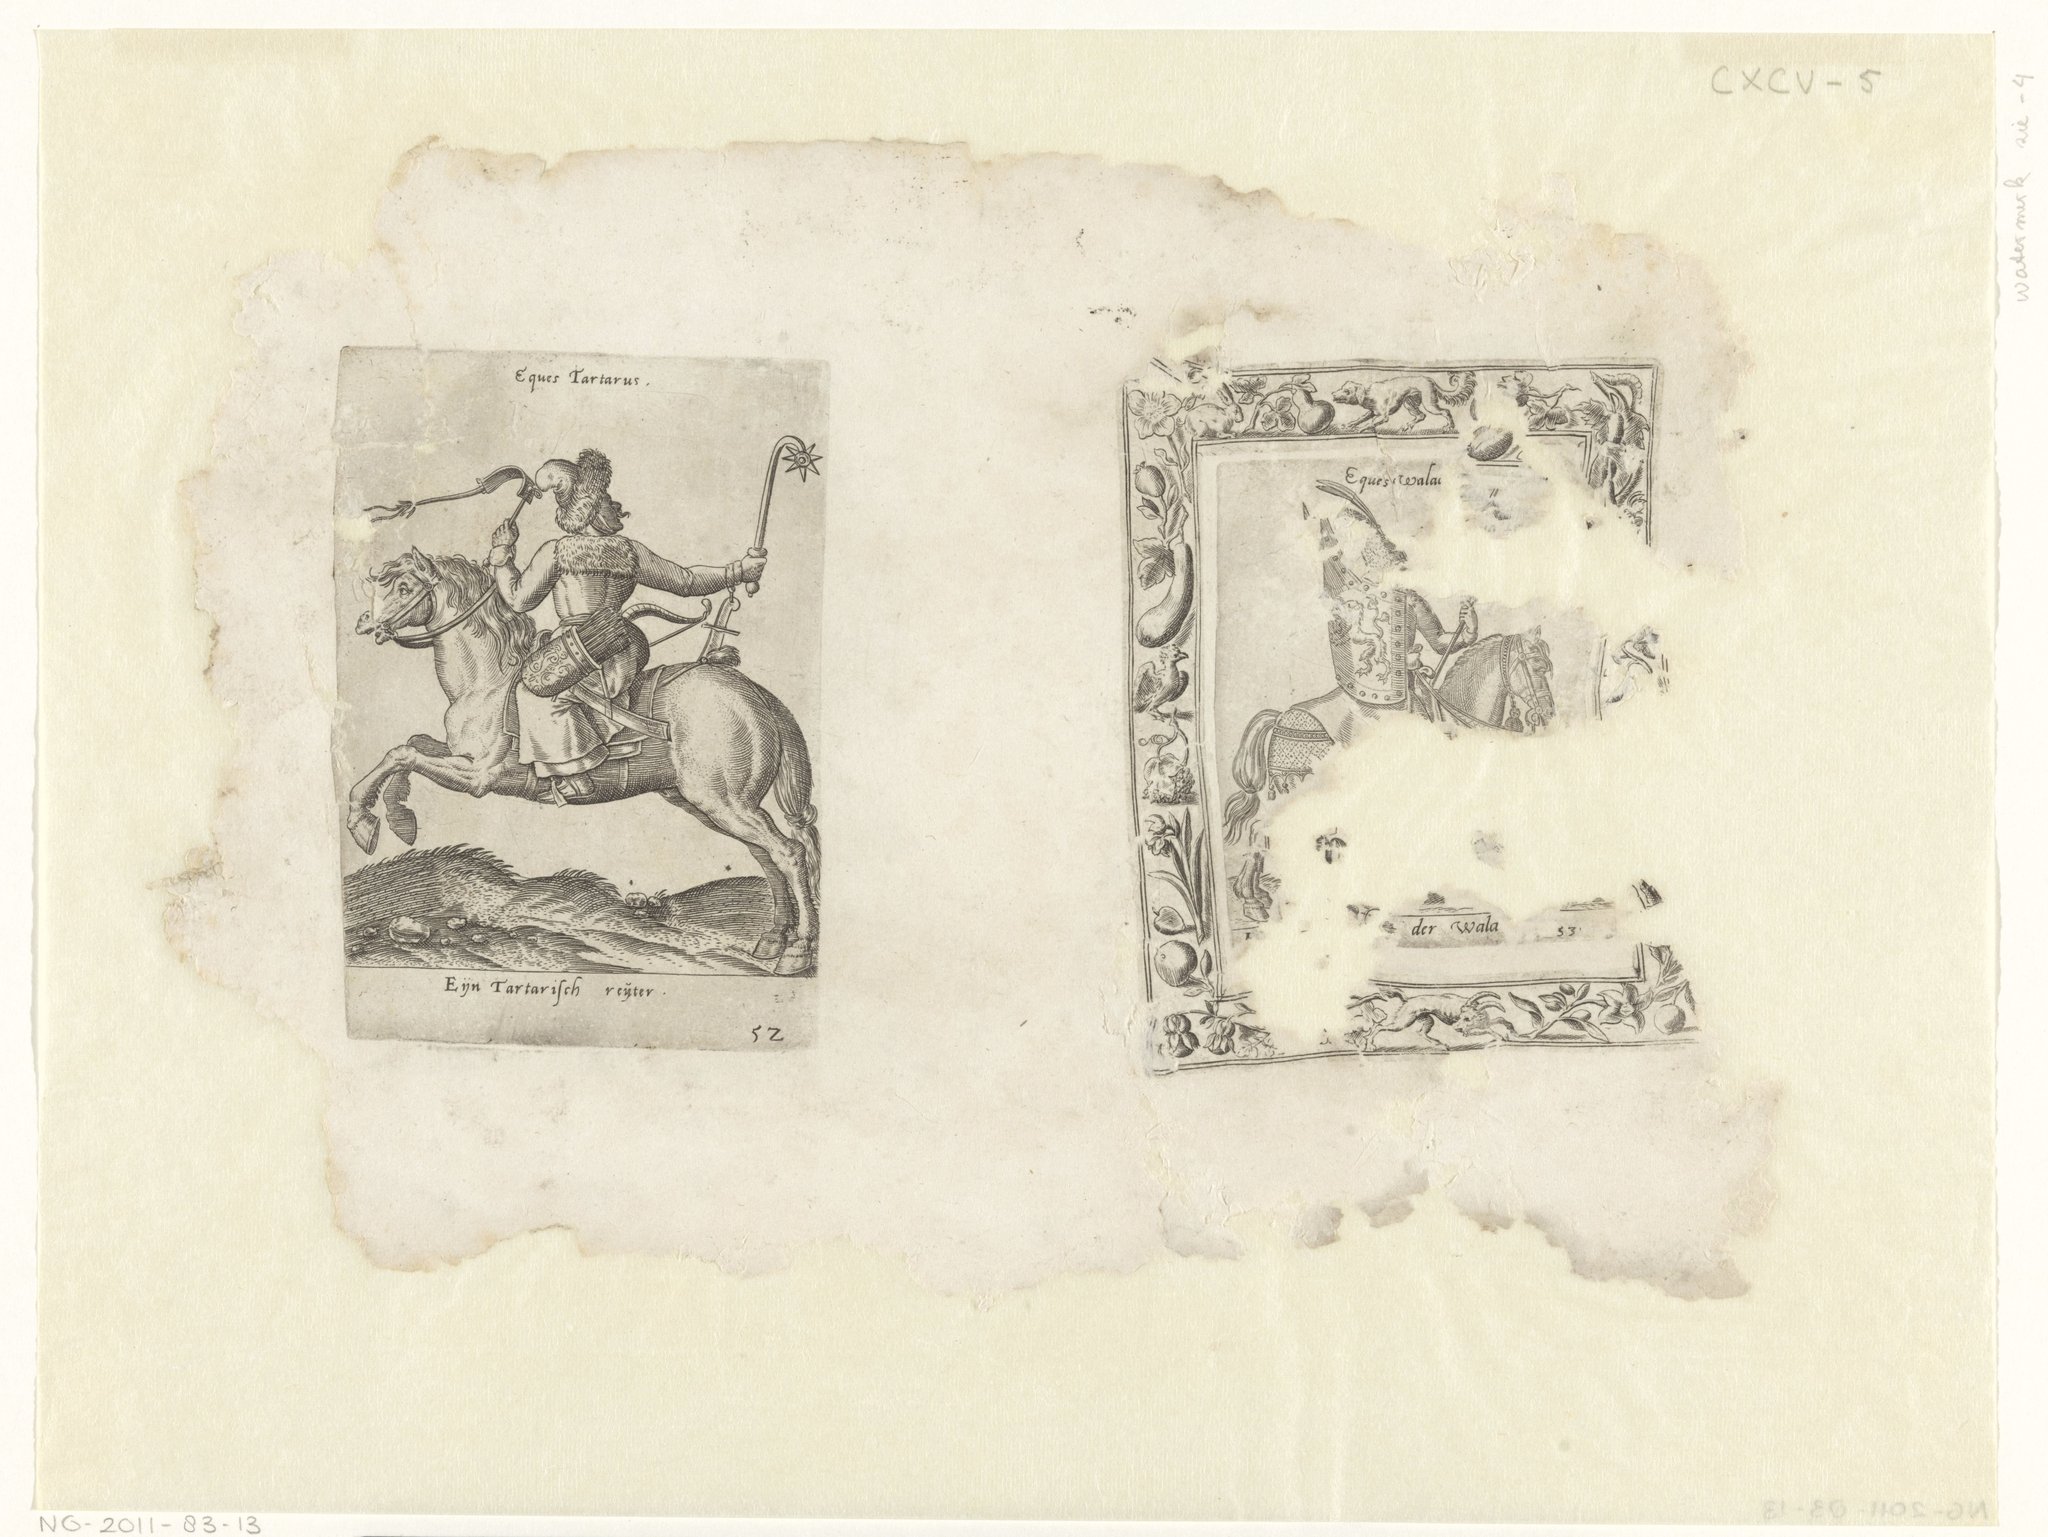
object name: costume print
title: Ruiterserie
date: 1576-1596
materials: paper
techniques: engraving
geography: cologne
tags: warfare; military affairs (+ cavalry, horsemen), folk costume, regional costume, military clothing and other equipment (uniforms, cap, armour, helmet, etc.)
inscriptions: watermark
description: Prent 52 en 53 uit een serie van 77, mogelijke serietitel Diversarum gentium armatura Equestris. Latere editie van serie Equitum Descripcio, Quomodo Equestres (...). De prenten in de Nova Zembla collectie zijn tijdens een expeditie van Willem Barendsz en Jacob van Heemskerk in 1596-1597 noodgedwongen in het winterkamp, het ‘Behouden Huis’, op het eiland achtergelaten. De prenten waren in één of meerdere stapels als handelswaar meegenomen vanuit Amsterdam. Bijna drie eeuwen later, in 1871, keerde de Noor Elling Carlsen terug naar Nova Zembla en vond daar de restanten van het ‘Behouden Huis, inclusief een groot deel van de inventaris. Een deel van de prenten, in de vorm van aaneengekoekte kluiten, werd toen ook teruggevonden. De papierkluiten waren soms op meerdere plekken gebroken. Tussen 1975-1979 zijn de prenten van elkaar gescheiden. Dit leverde in totaal ca. 1000 fragmenten van ca. 400 afdrukken van ca. 150 verschillende prenten op. Voor zover mogelijk zijn de fragmenten samengevoegd en zijn de prenten gereconstrueerd.